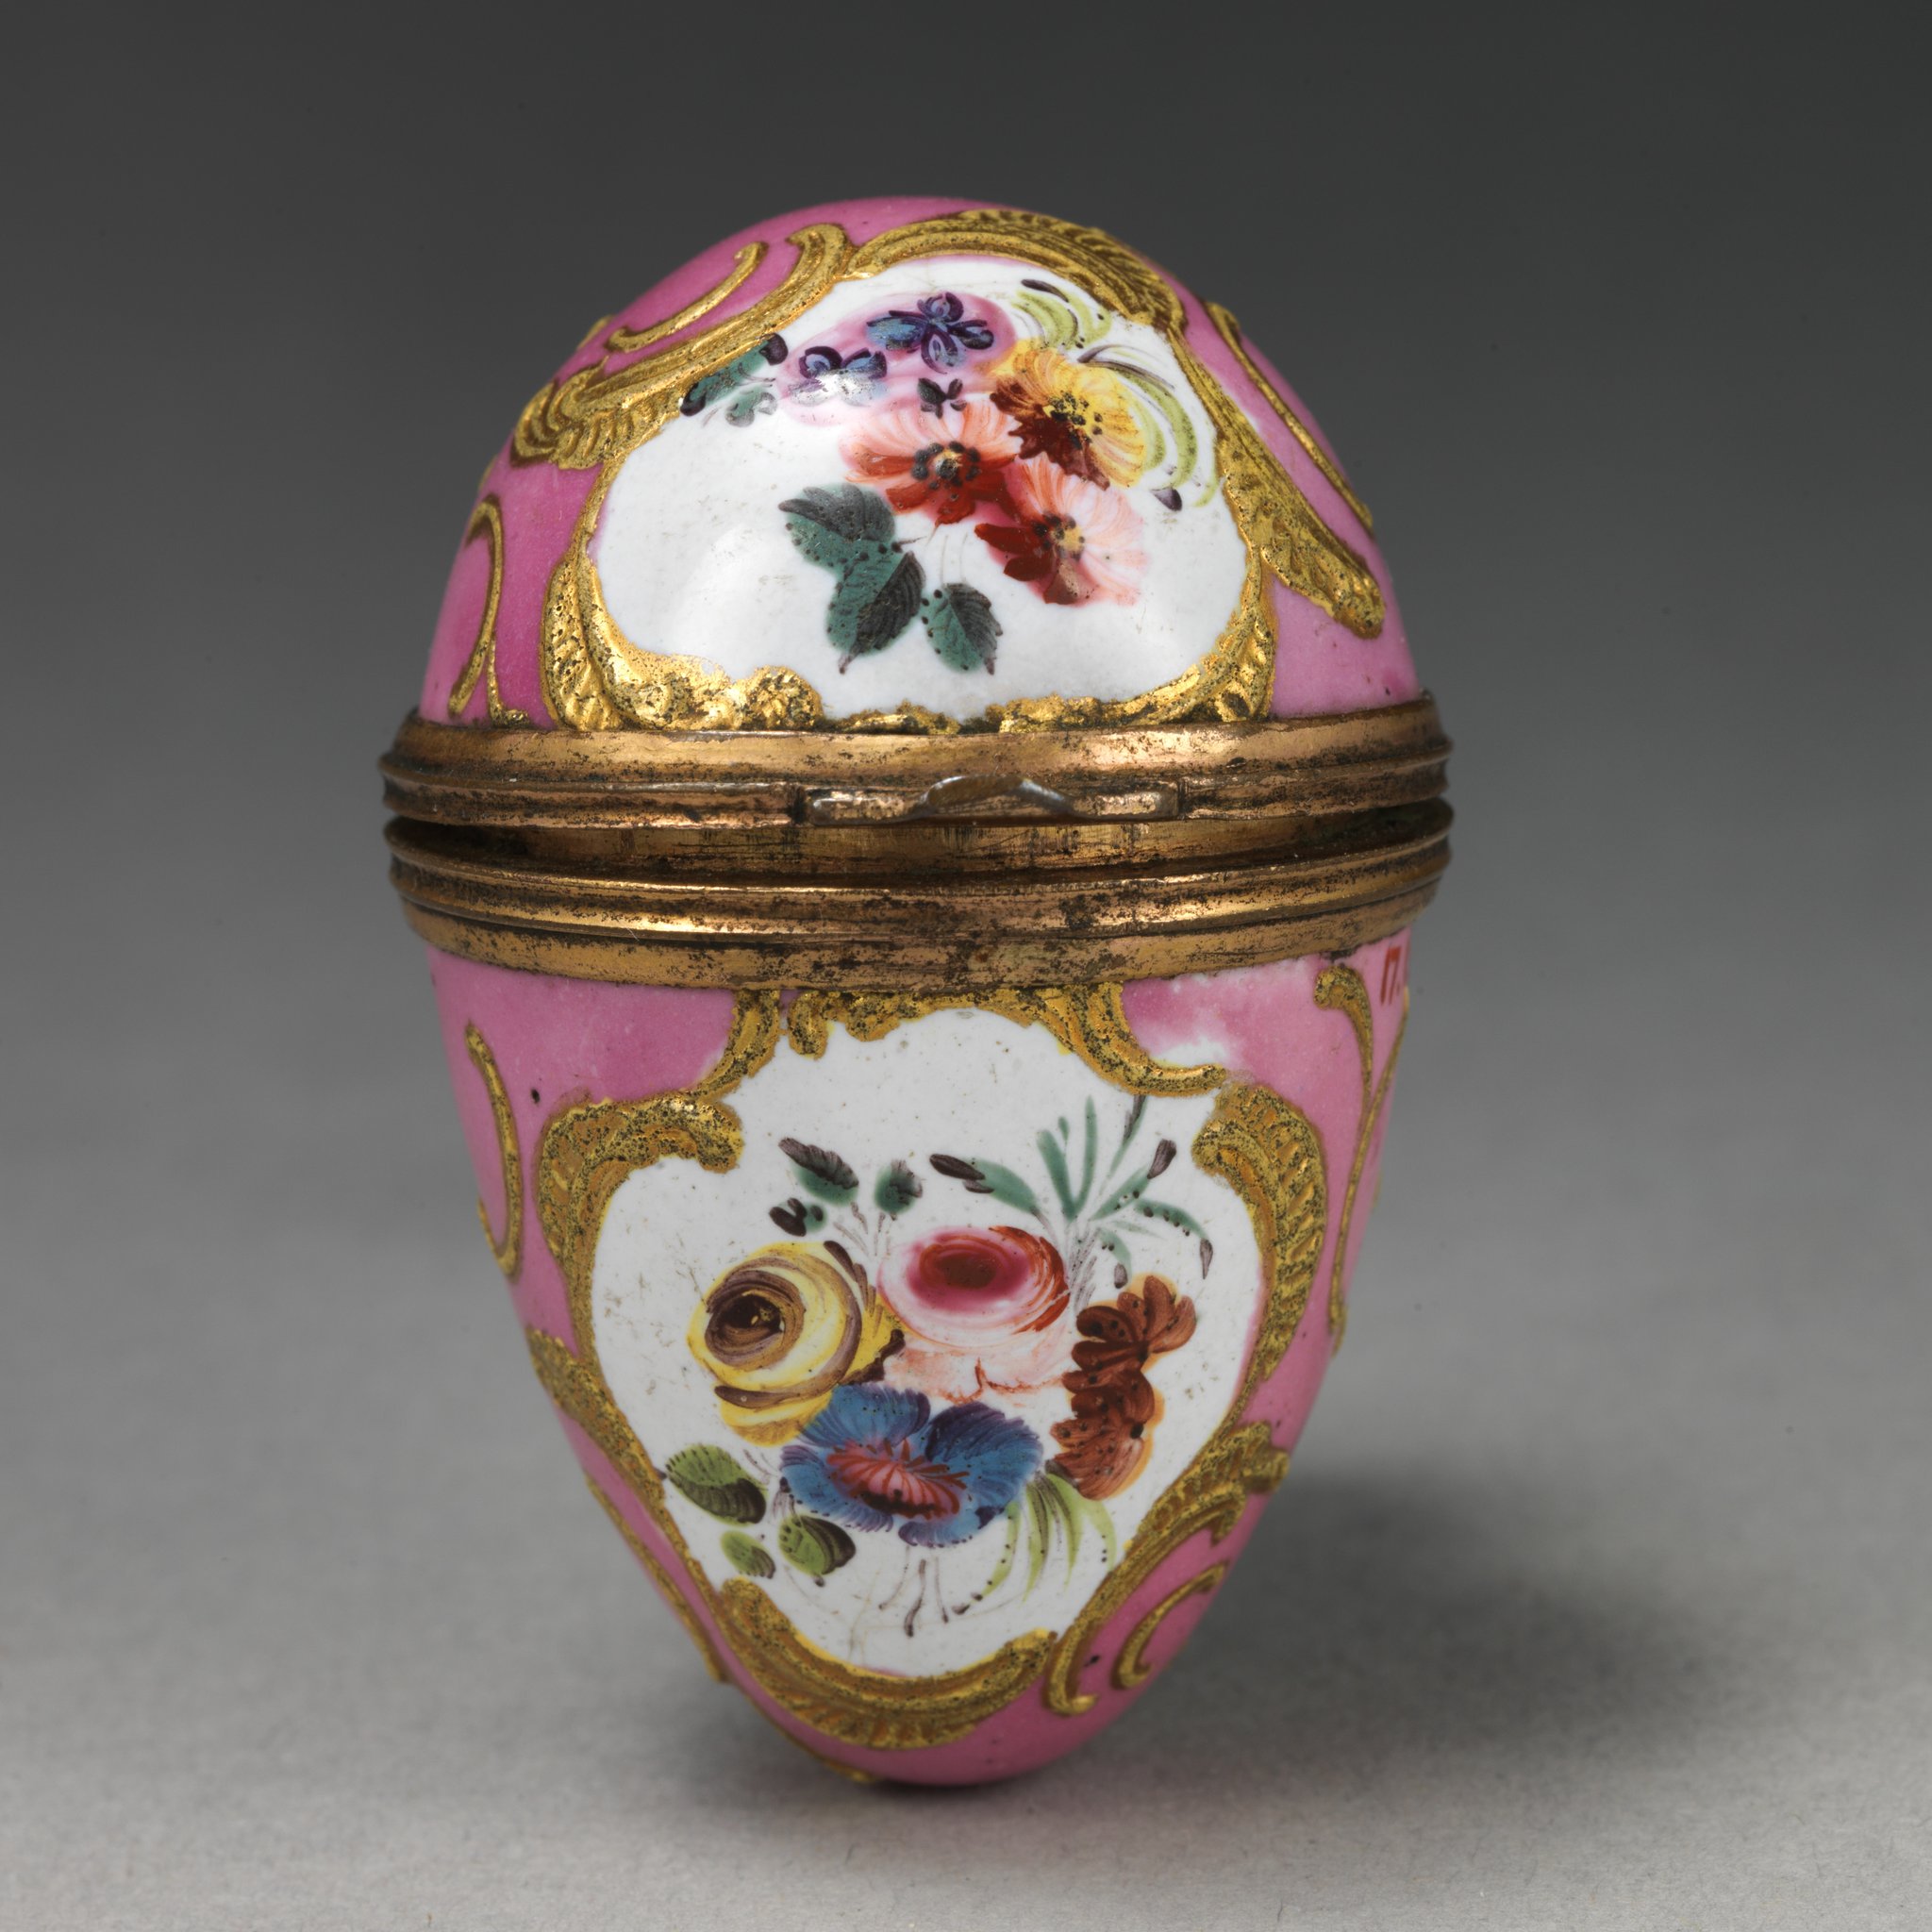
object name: egg shaped box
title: possibly Thimble case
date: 1770-1780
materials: copper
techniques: enamel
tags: flowers,leaves